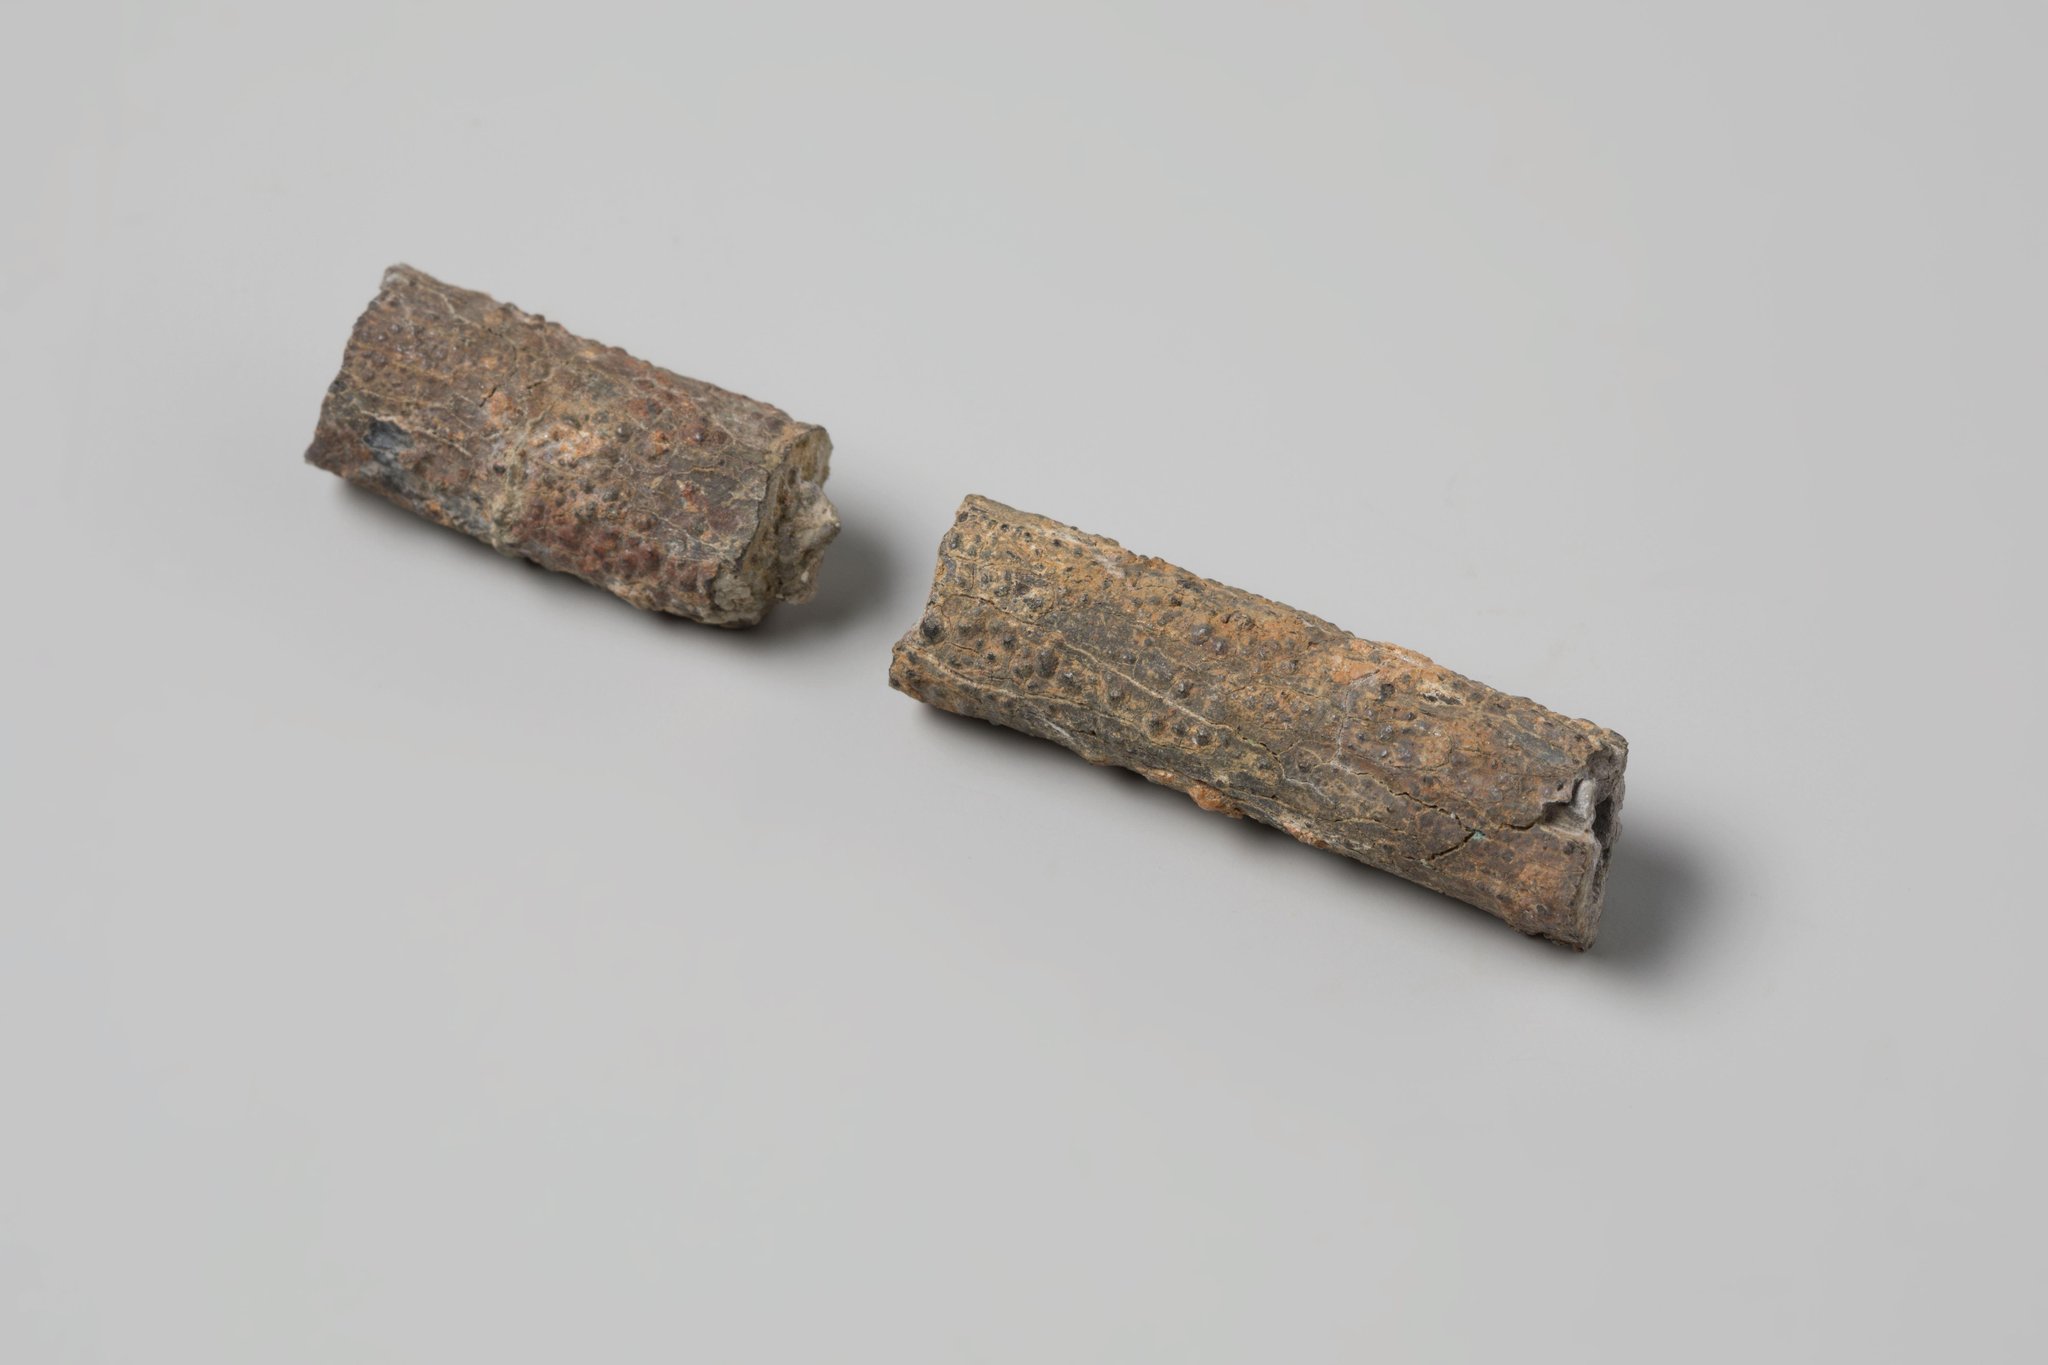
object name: enema syringe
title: Onderdelen klisteerspuit uit het wrak van de Oost-Indiëvaarder Hollandia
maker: Anonymous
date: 1700-1743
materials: tin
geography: netherlands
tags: verenigde oostindische compagnie, hollandia (schip), annet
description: Tools and instruments, medical, enema syringe; fragm of needles, heavily corroded: tubes, broken off, id. NG 1980-27H1799/1632.